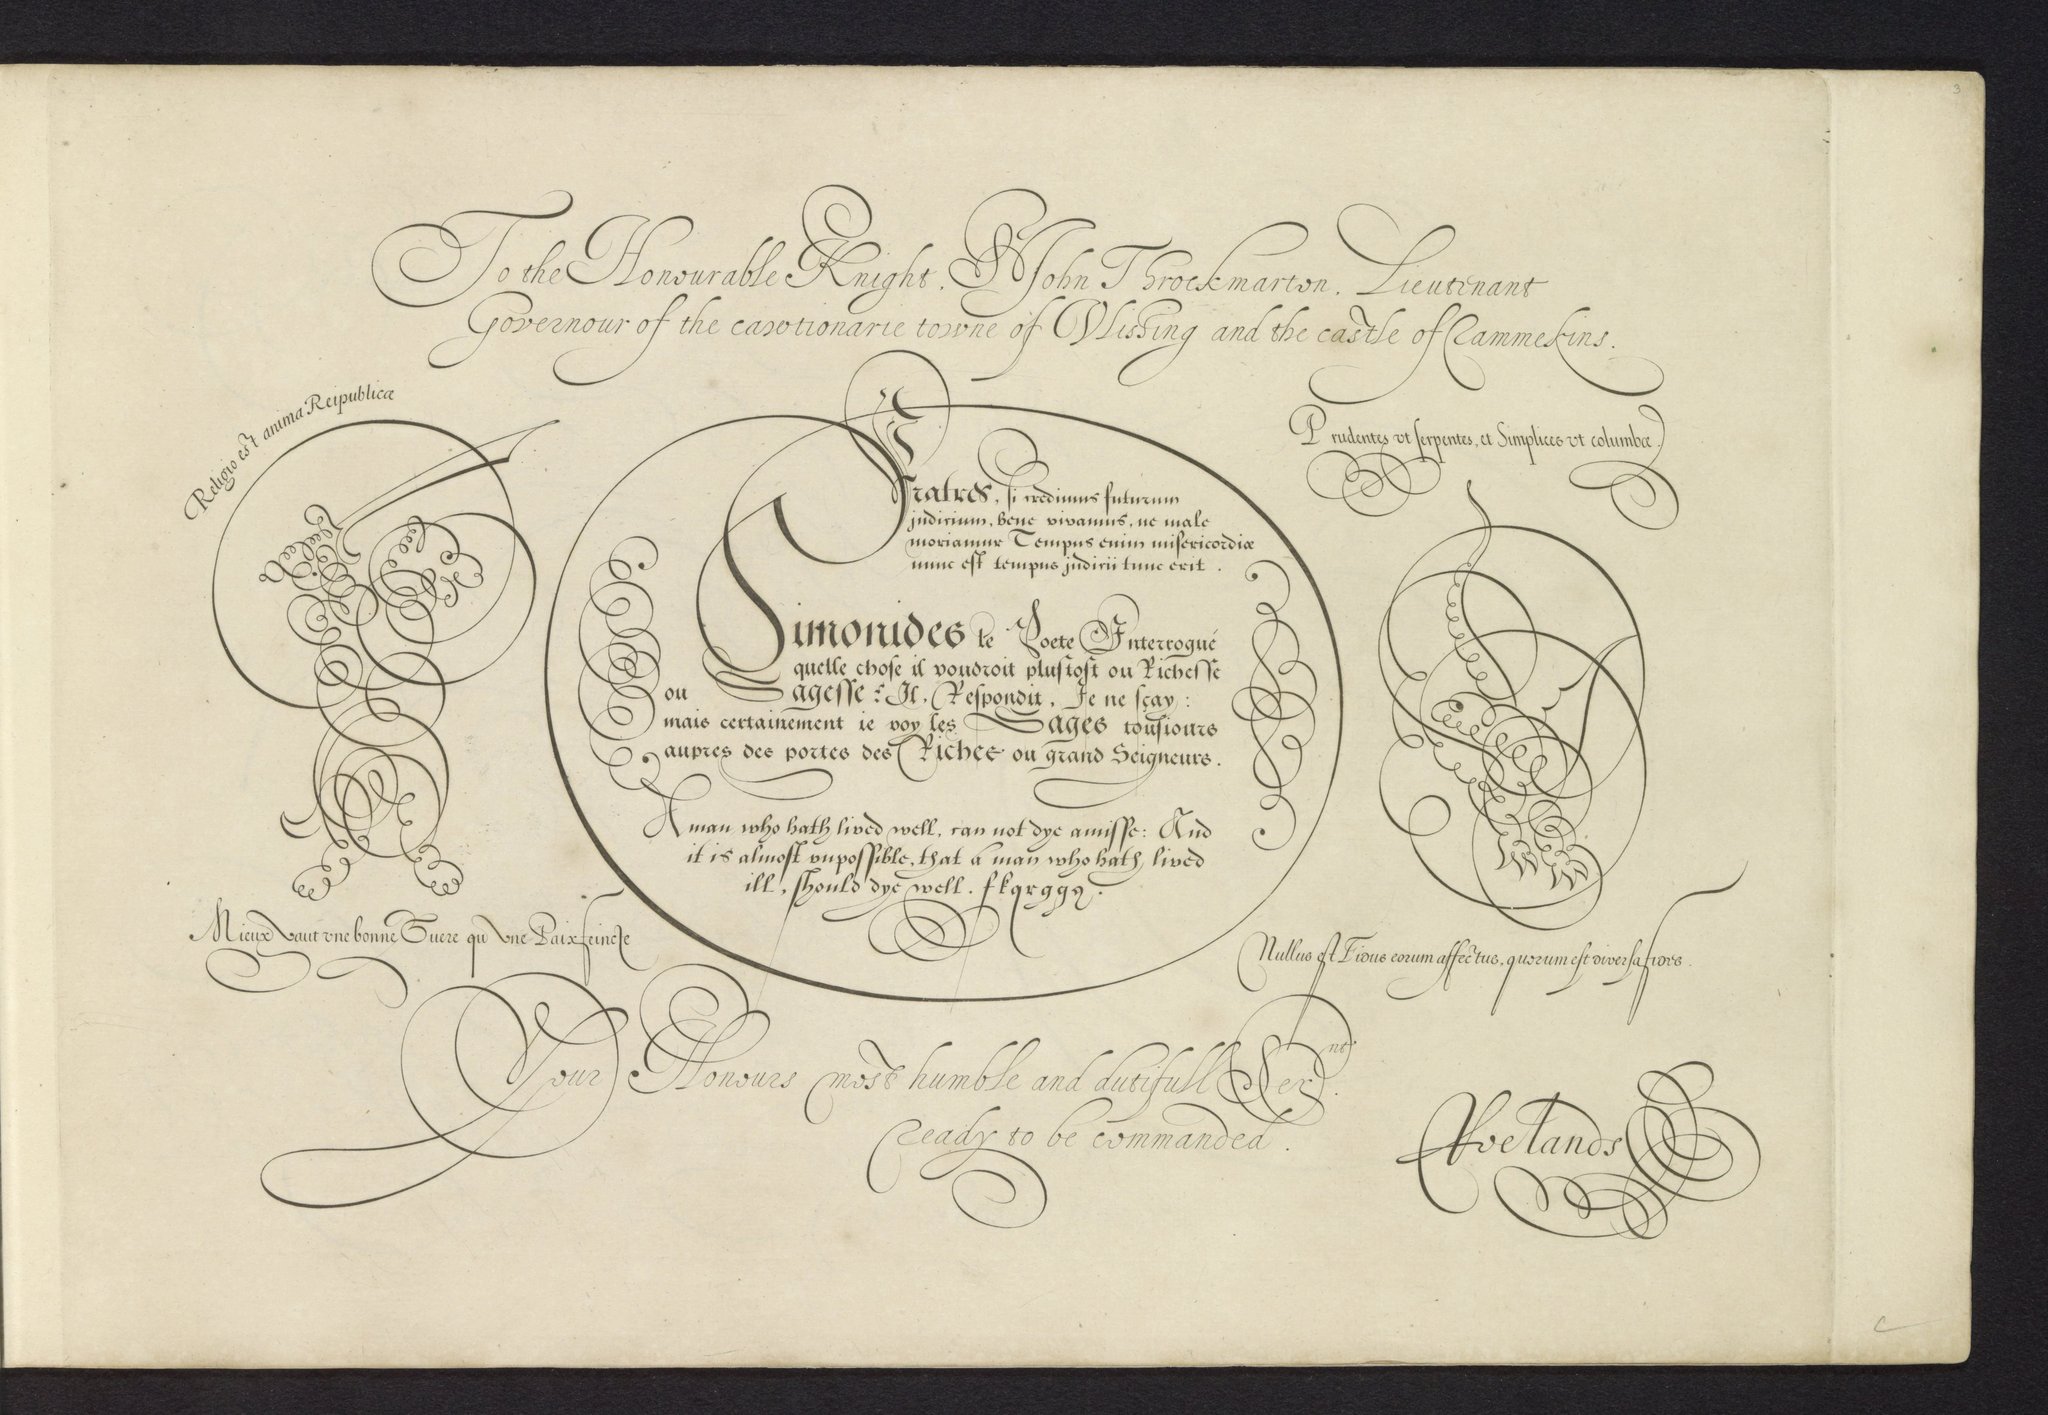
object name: print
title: Schrijfvoorbeeld: Fratres, si credimus (...)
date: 1616-1617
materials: paper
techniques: engraving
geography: flushing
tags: calligraphy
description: Schrijfvoorbeeld met teksten in het Latijn, Frans en Engels: Fratres, si credimus ... / Simonides le Poete ... / A man who hath lived well ... Daarboven een tweeregelige tekst met een opdracht aan Sir John Throckmorton, Engels commandant van Vlissingen. De tekst wordt geflankeerd door een beer met zwaard en een gevleugelde draak in krulwerk. De prent maakt deel uit van een album getiteld: Prijs boek van Jan Malnoe.